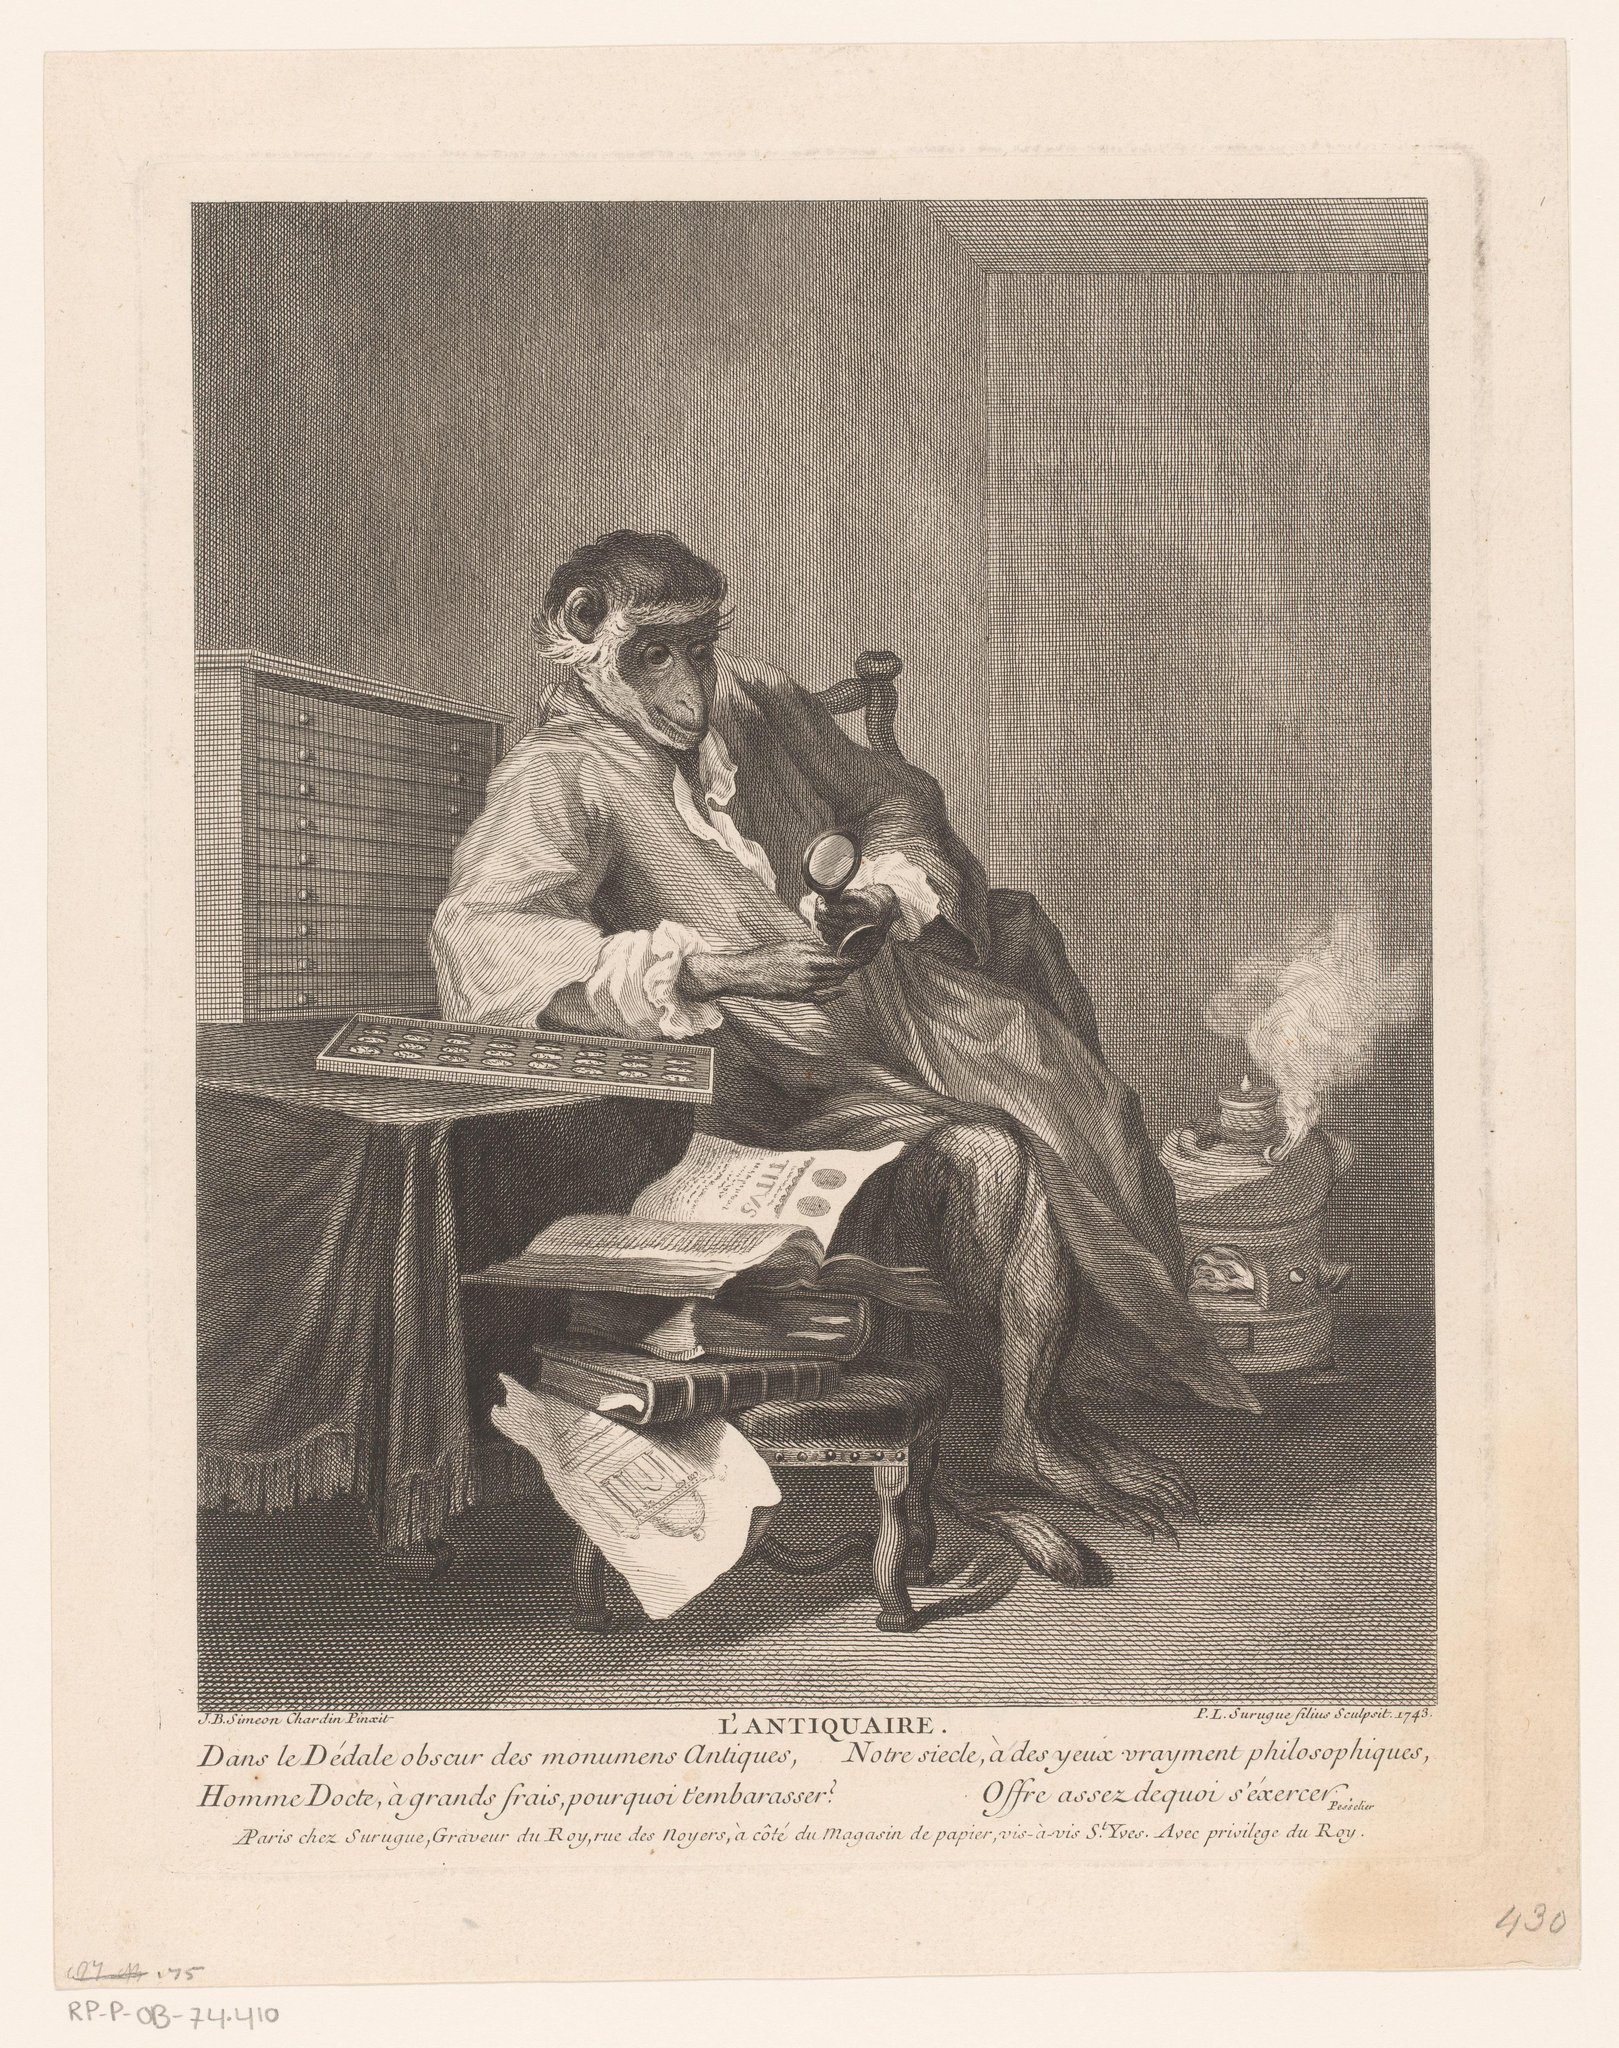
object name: print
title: L'Antiquaire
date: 1743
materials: paper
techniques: engraving, etching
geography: paris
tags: antique dealer, monkeys, apes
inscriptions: collector's mark: Lugt 2228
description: Interieur met geklede aap die zijn collectie munten en boeken bestudeert.